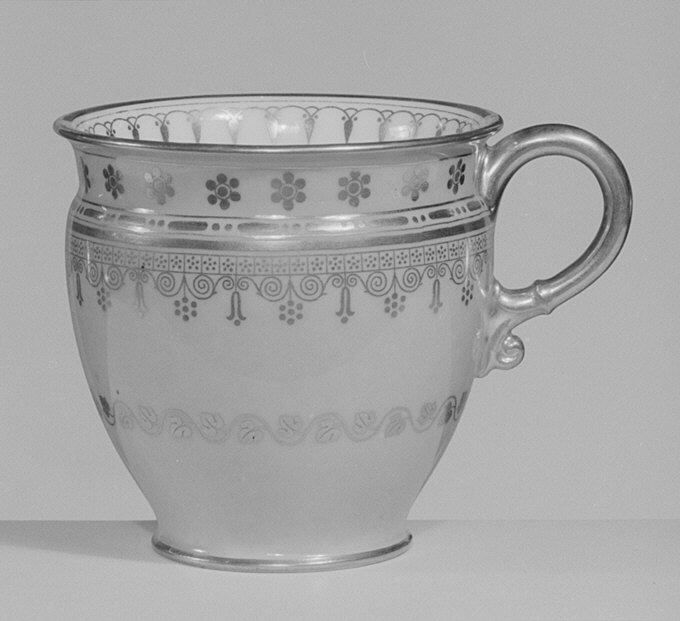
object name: cup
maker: sèvres manufactory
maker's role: manufactory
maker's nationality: french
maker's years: 1740-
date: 1855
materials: hard paste porcelain